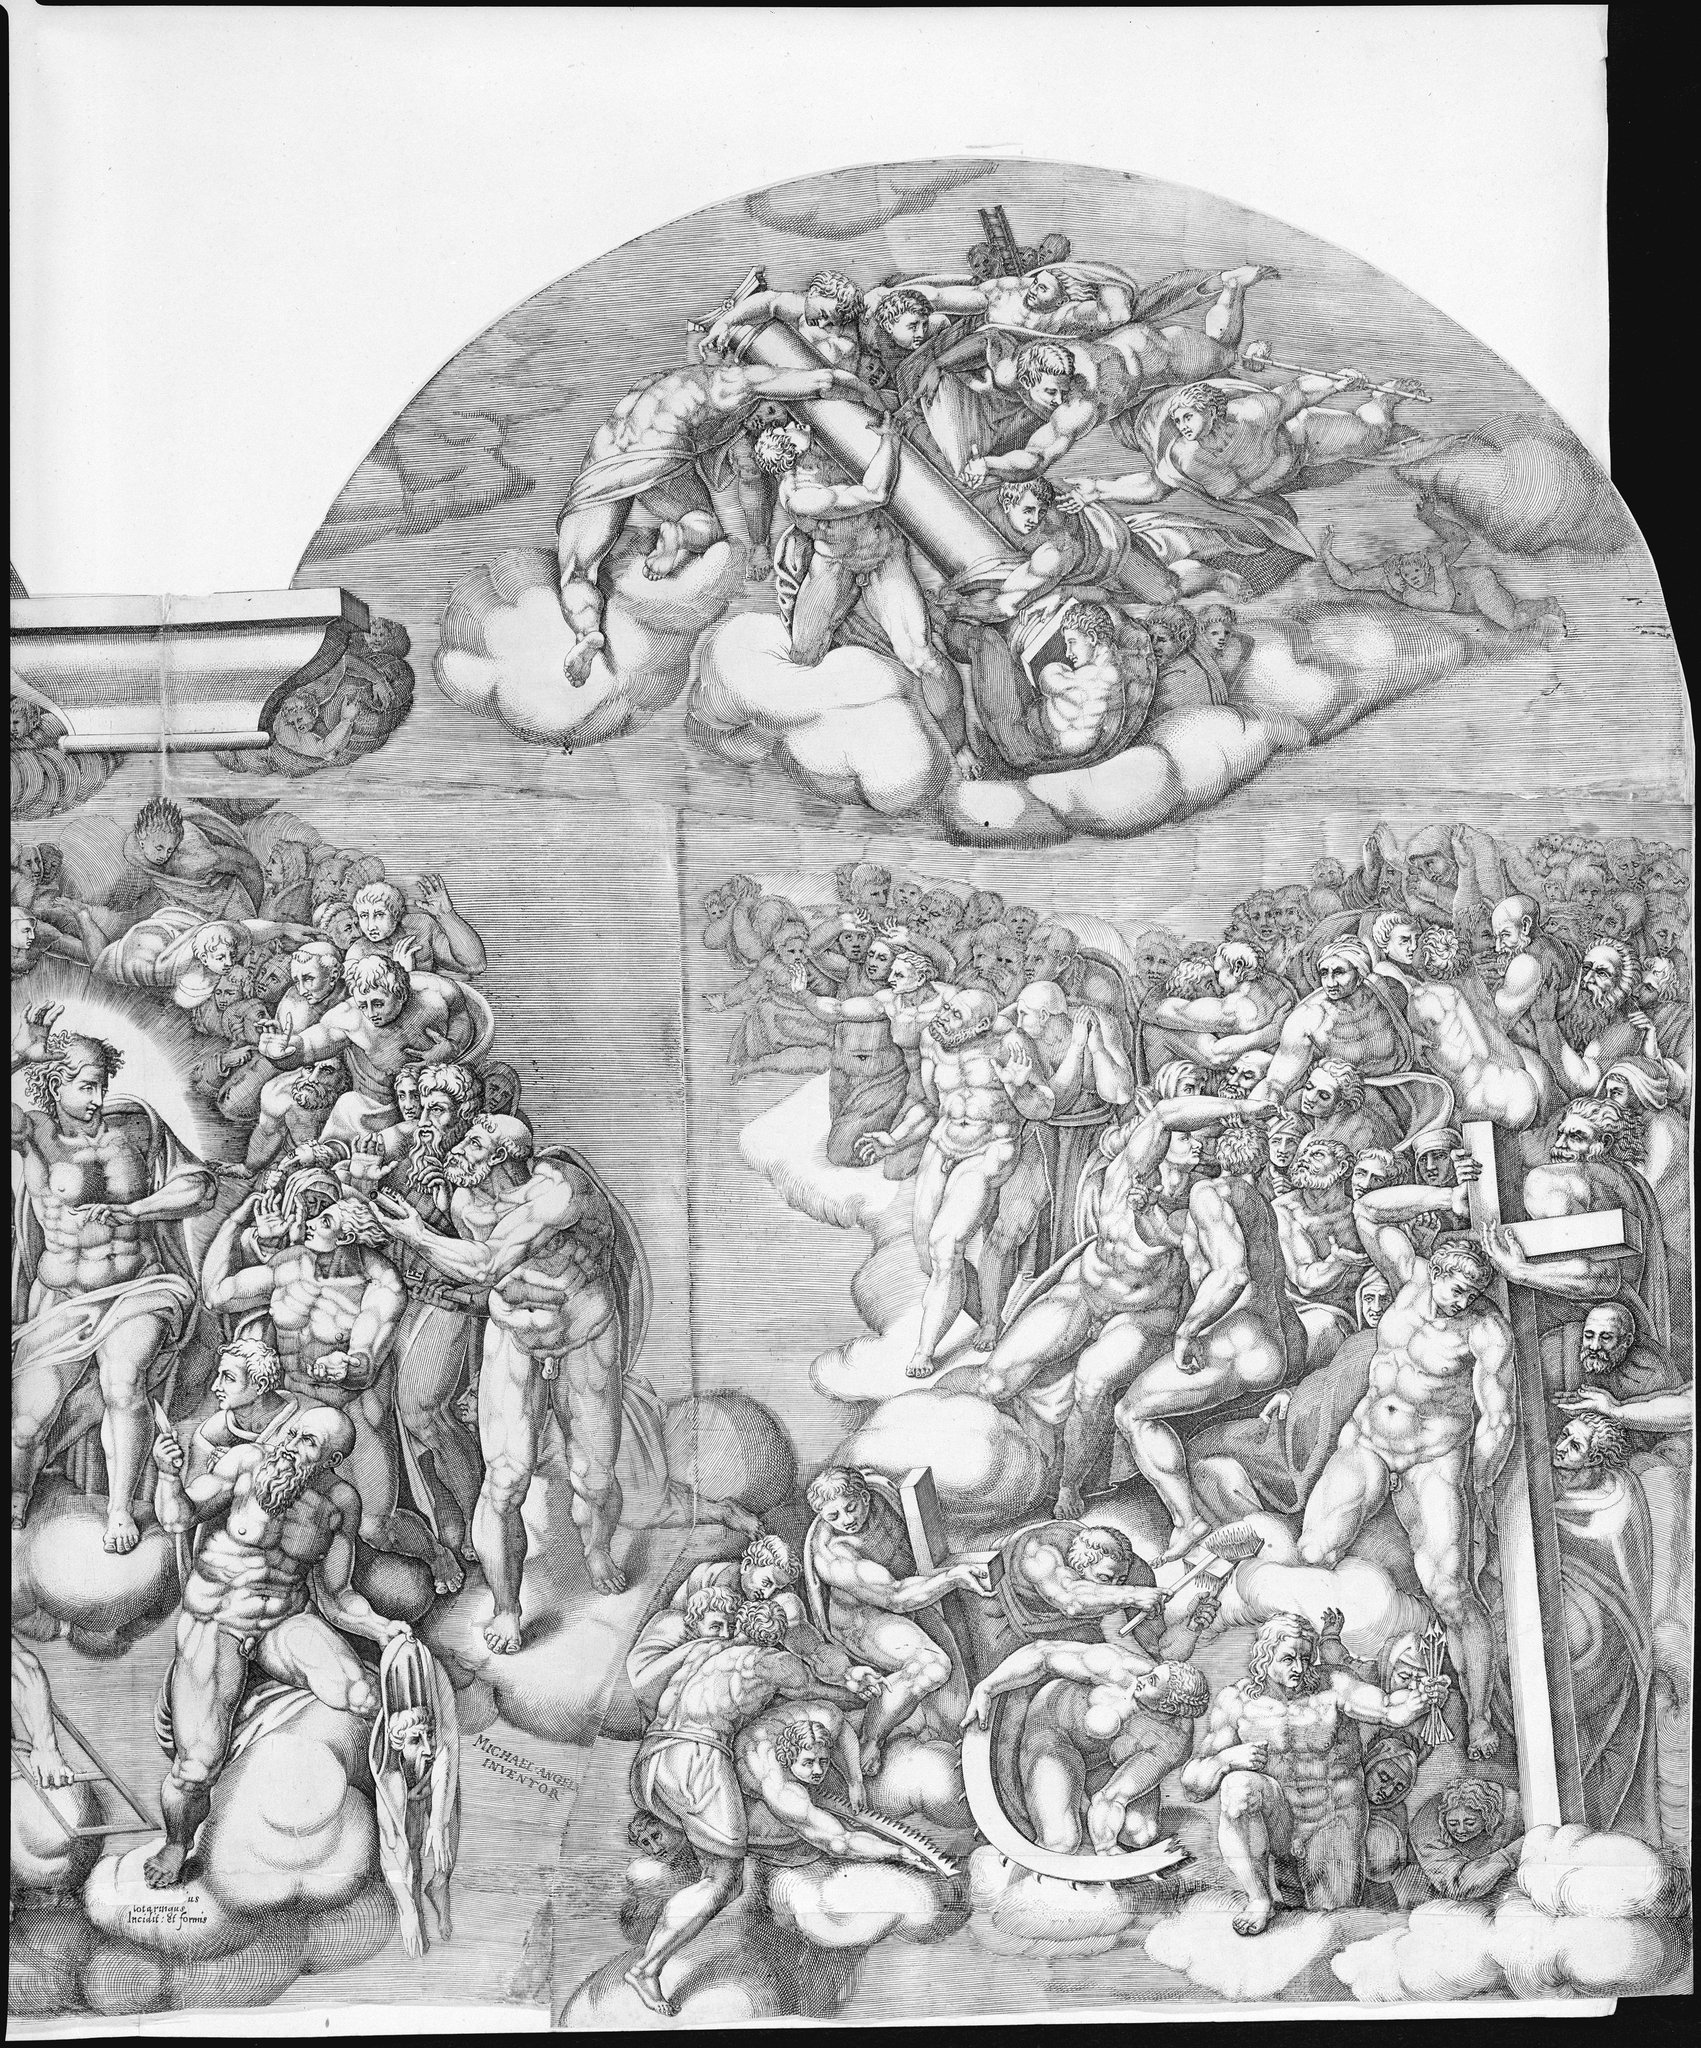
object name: print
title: Michelangelo's Last Judgment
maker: nicolas beatrizet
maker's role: artist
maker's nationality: french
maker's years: 1515-1566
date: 1562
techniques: engraving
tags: last judgement